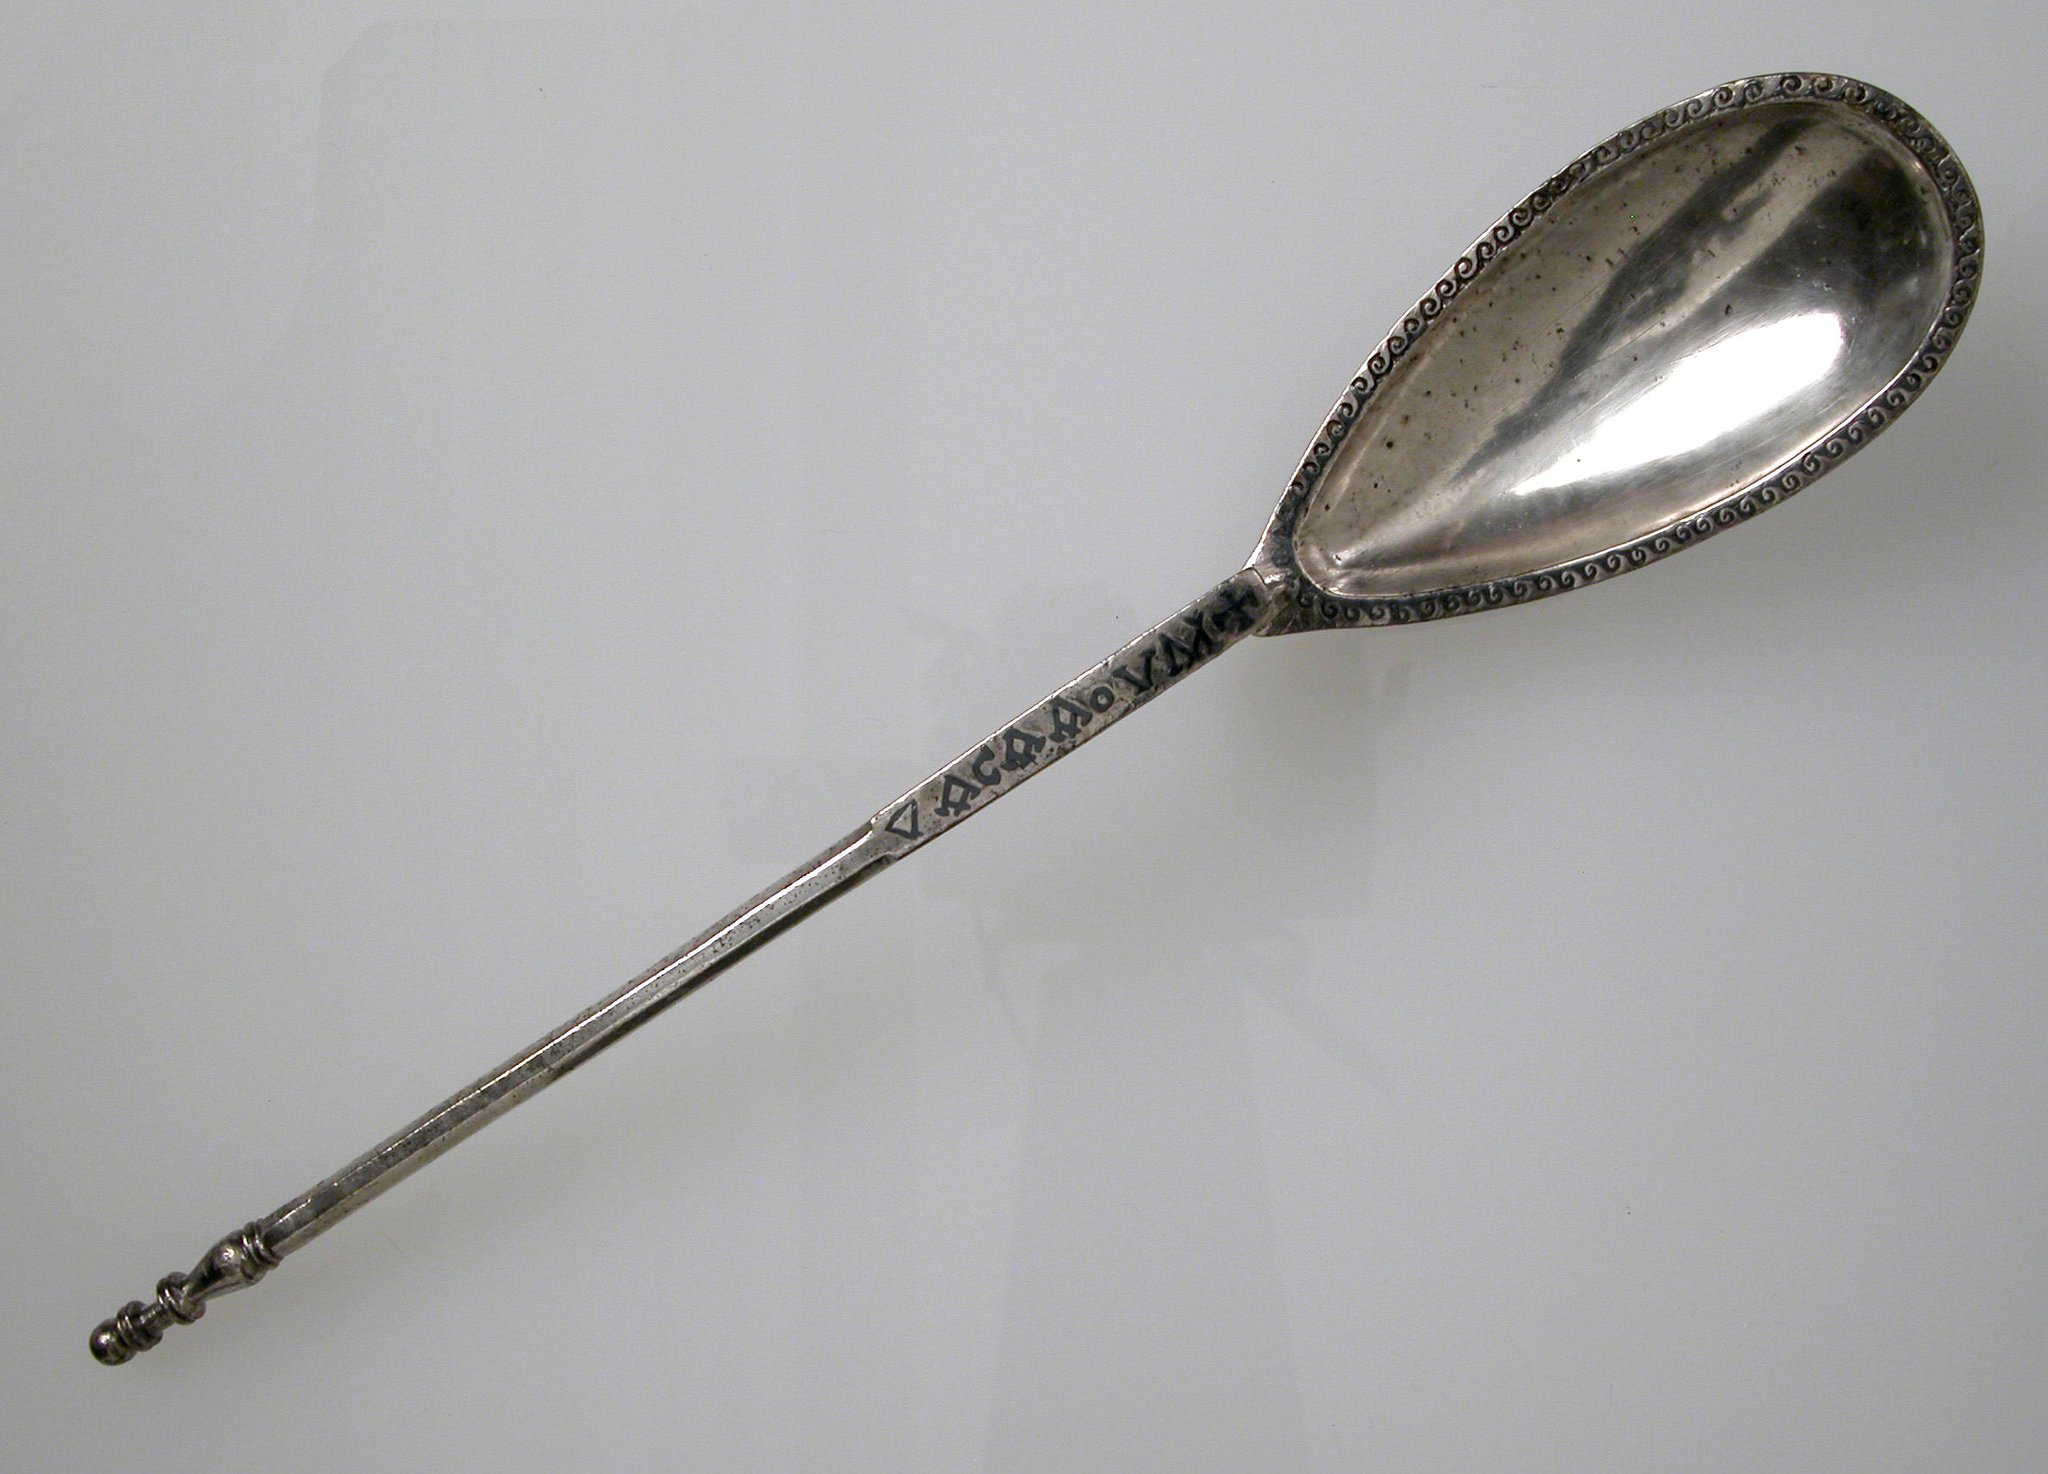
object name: spoon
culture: byzantine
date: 401-600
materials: niello, silver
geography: syria